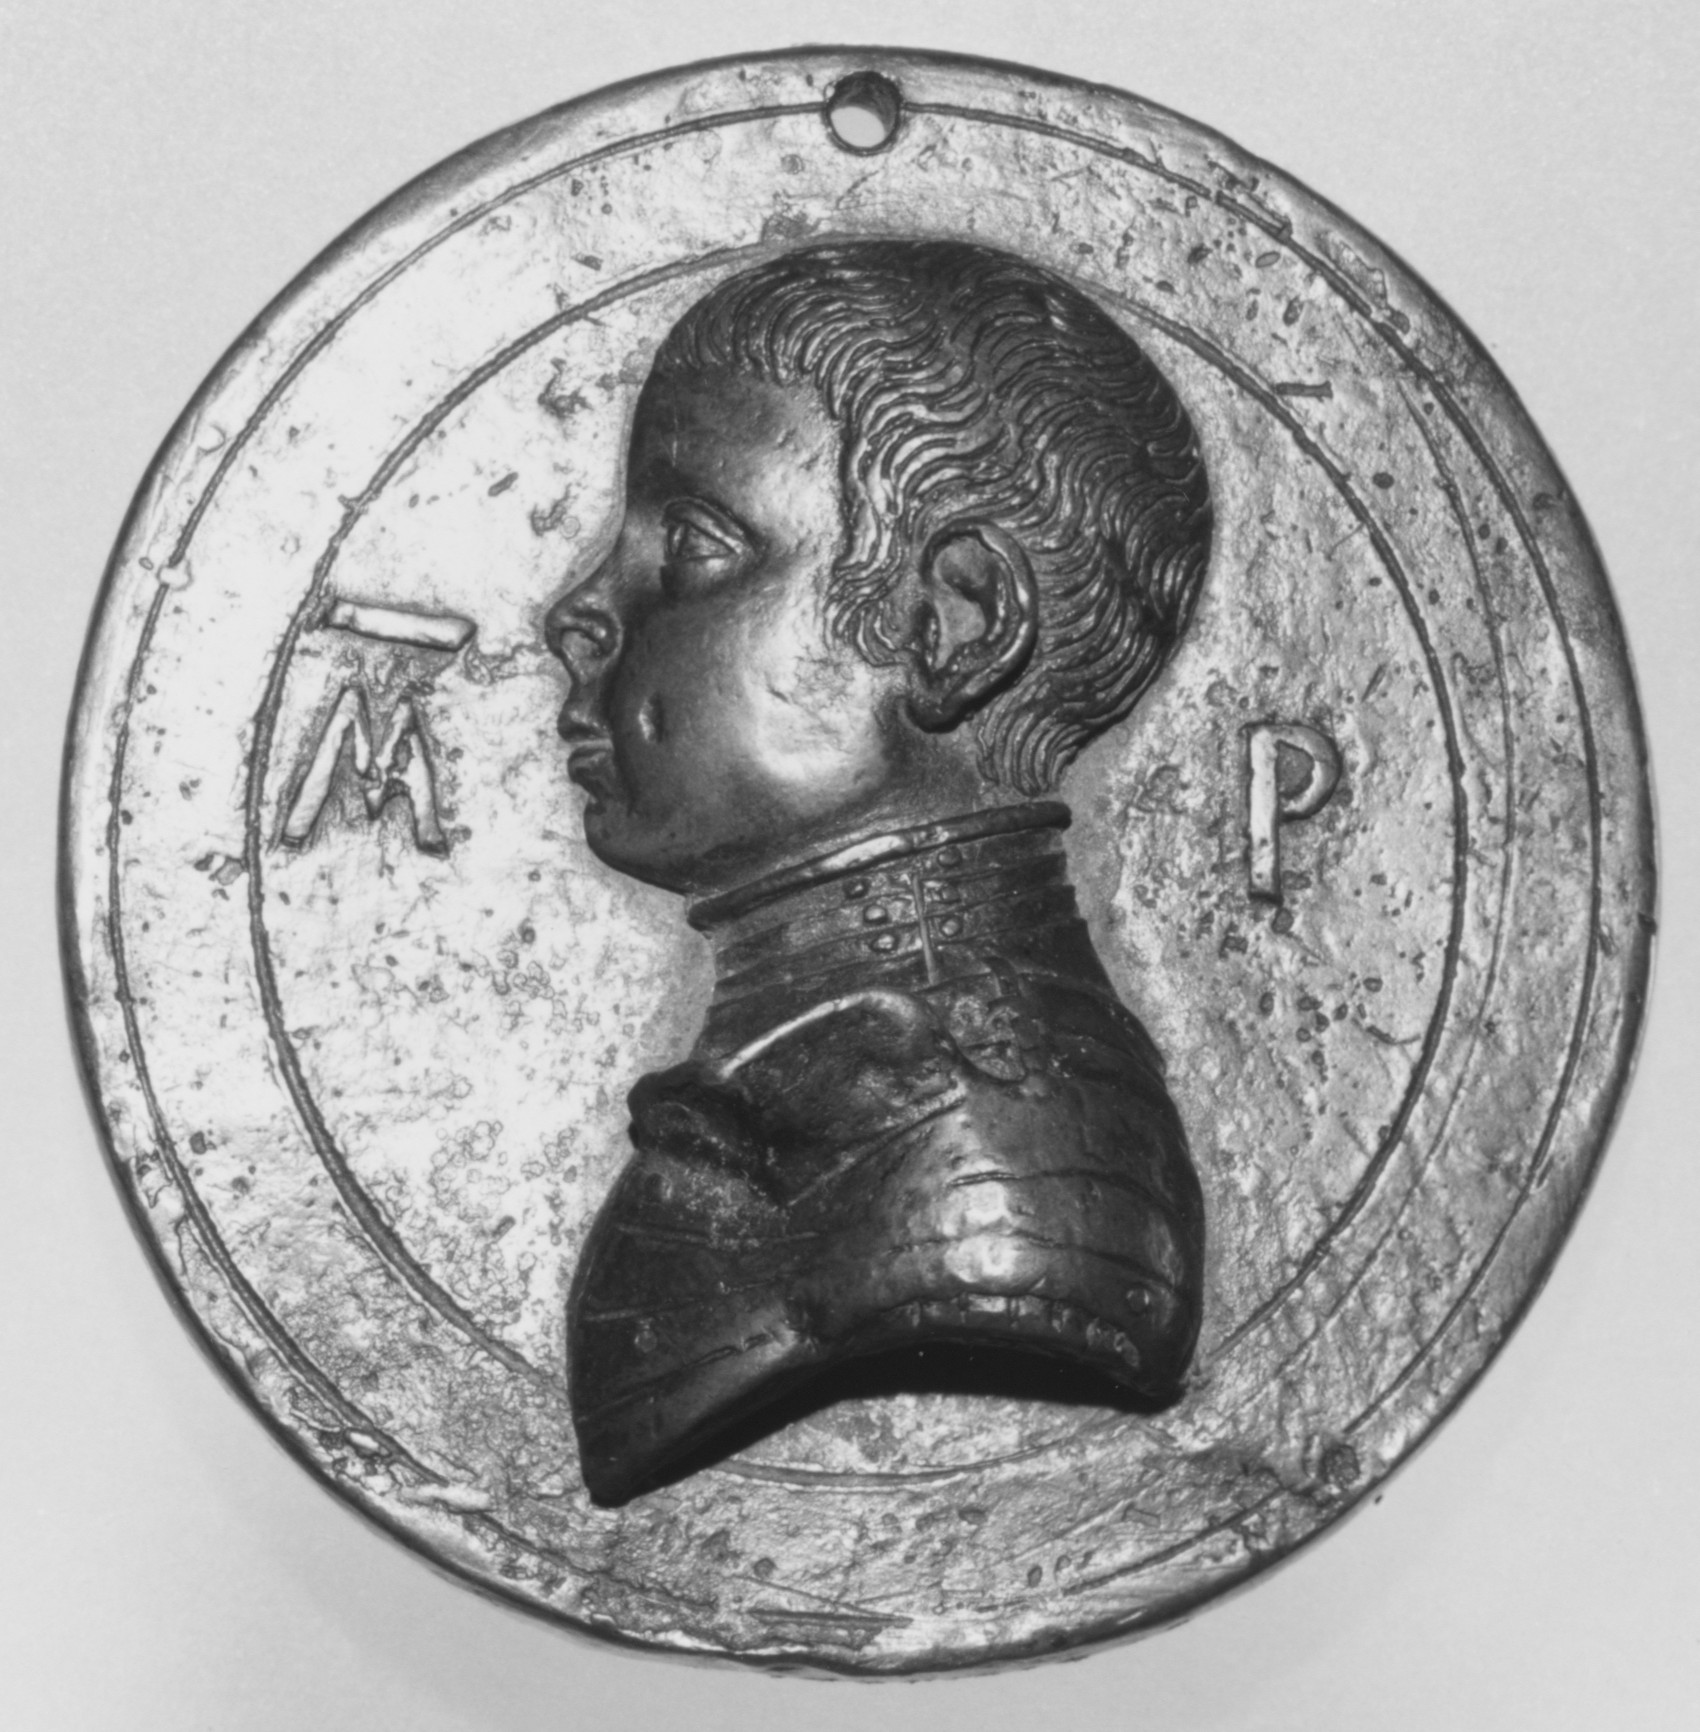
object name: medal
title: Young Boy, Member of the Family of Pio di Savoia, Counts of Carpi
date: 1501-1600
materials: bronze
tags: boys,profiles